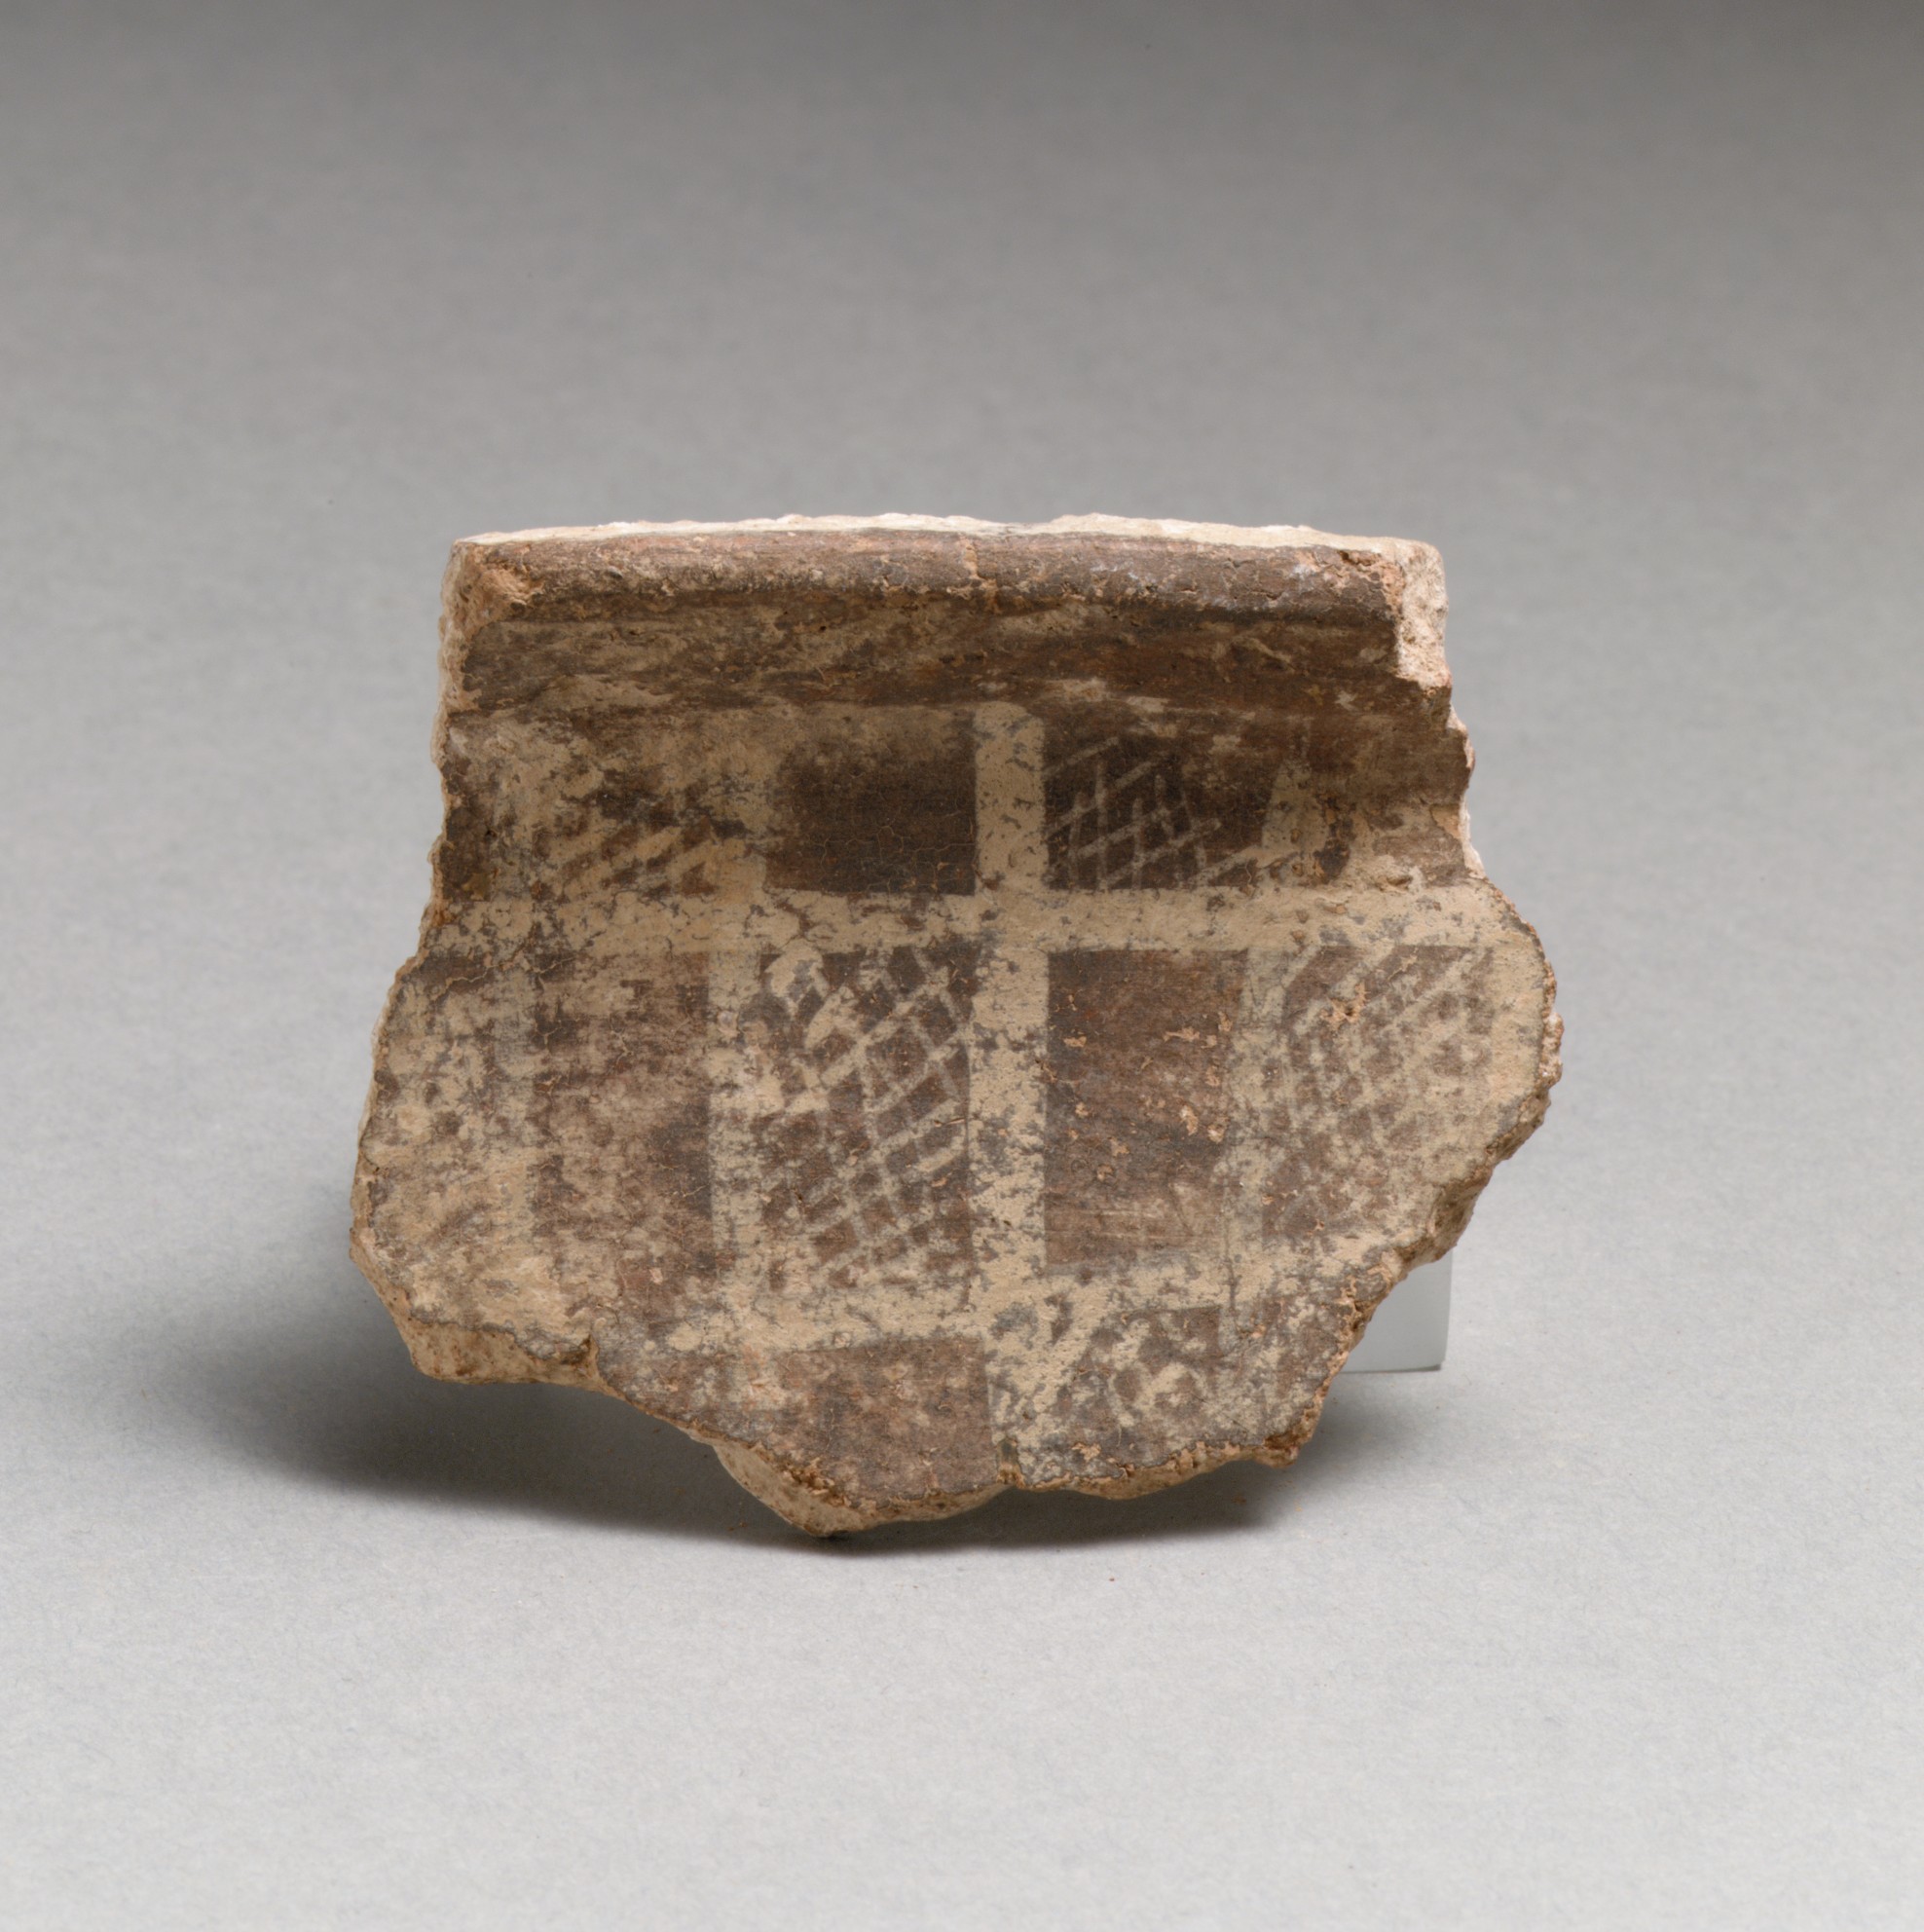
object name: vase fragment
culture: minoan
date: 2600-2000 BCE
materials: terracotta